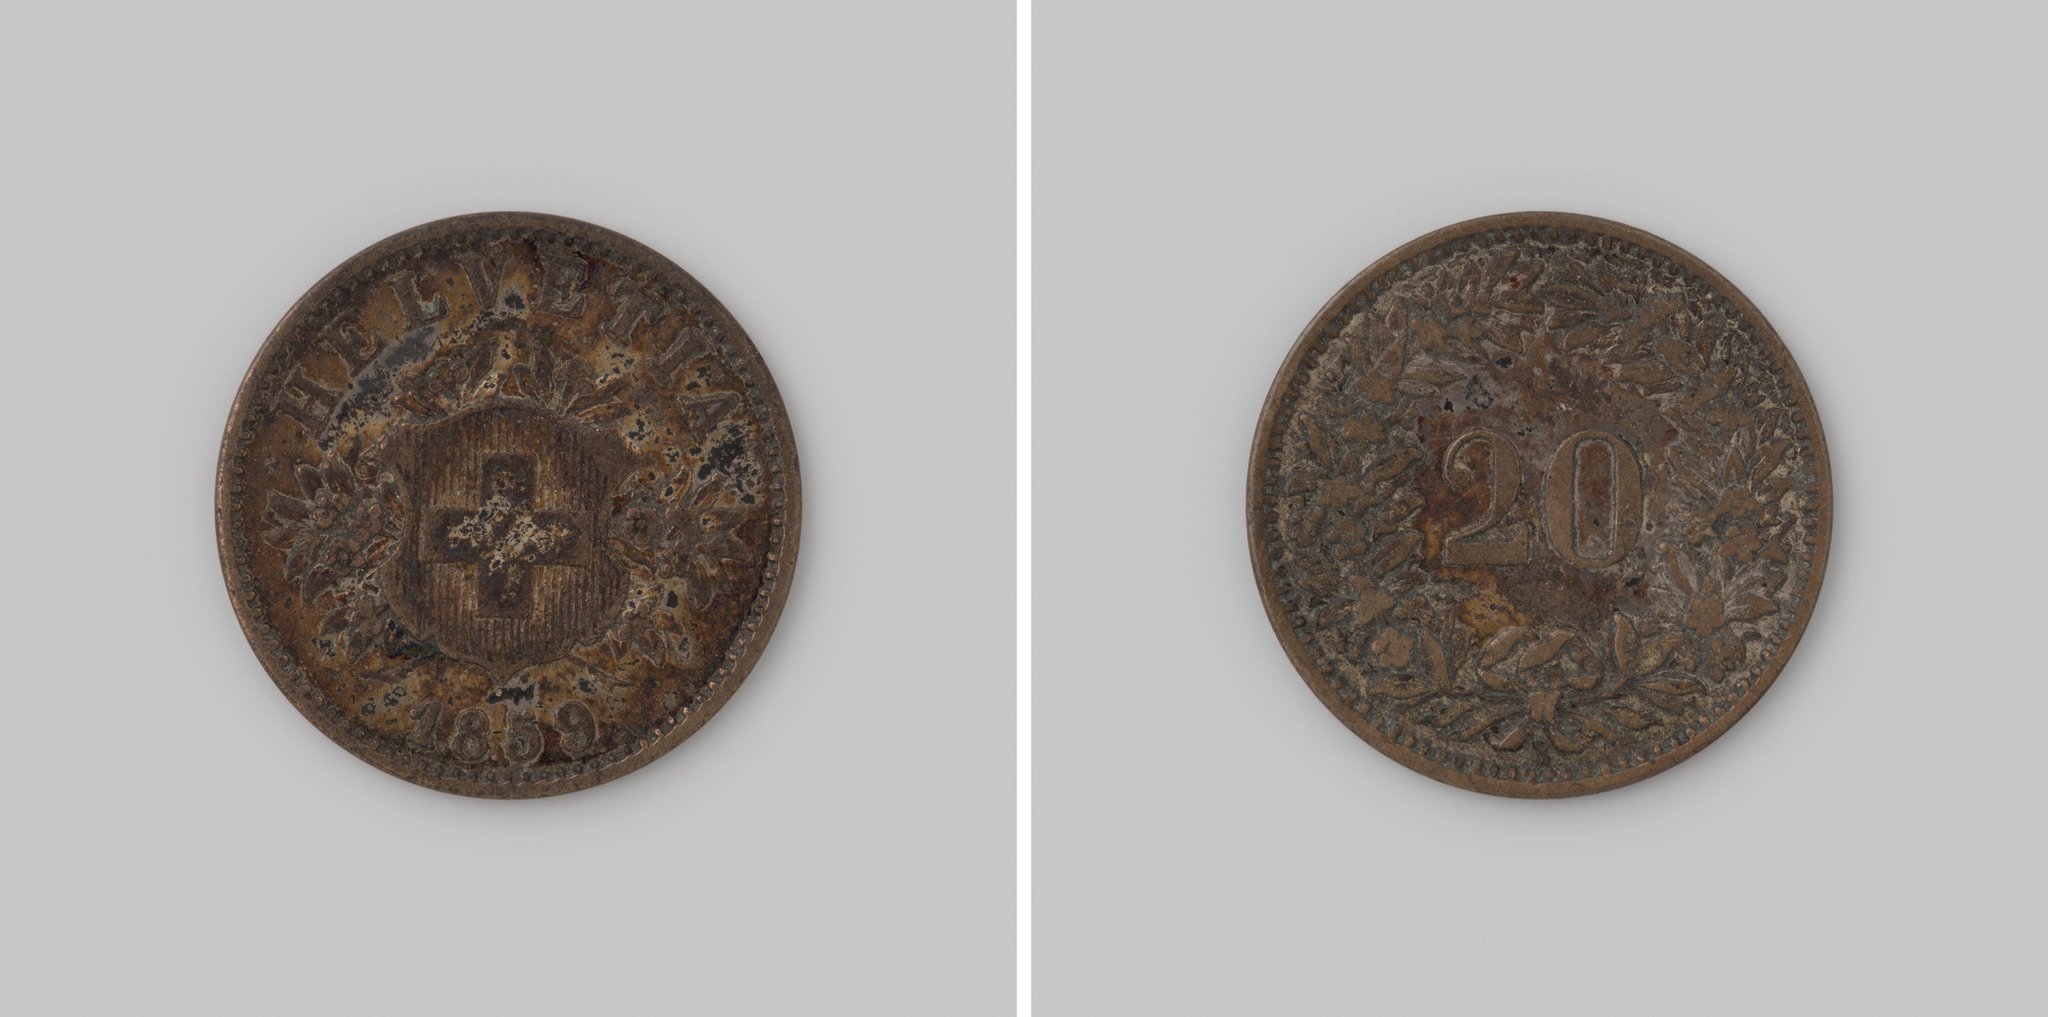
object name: twintig centime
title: 20 centimes uit Zwitserland, 1859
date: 1859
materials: nickel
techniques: striking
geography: bern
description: Nikkelen munt. Voorzijde: het wapenschild van Zwitserland tegen een achtergrond van bloemen. Jaartal onderaan. Keerzijde: binnen twee samengebonden takken in een regel waarde-aanduiding. Onderaan letter B [=Bern]. Gladde rand.